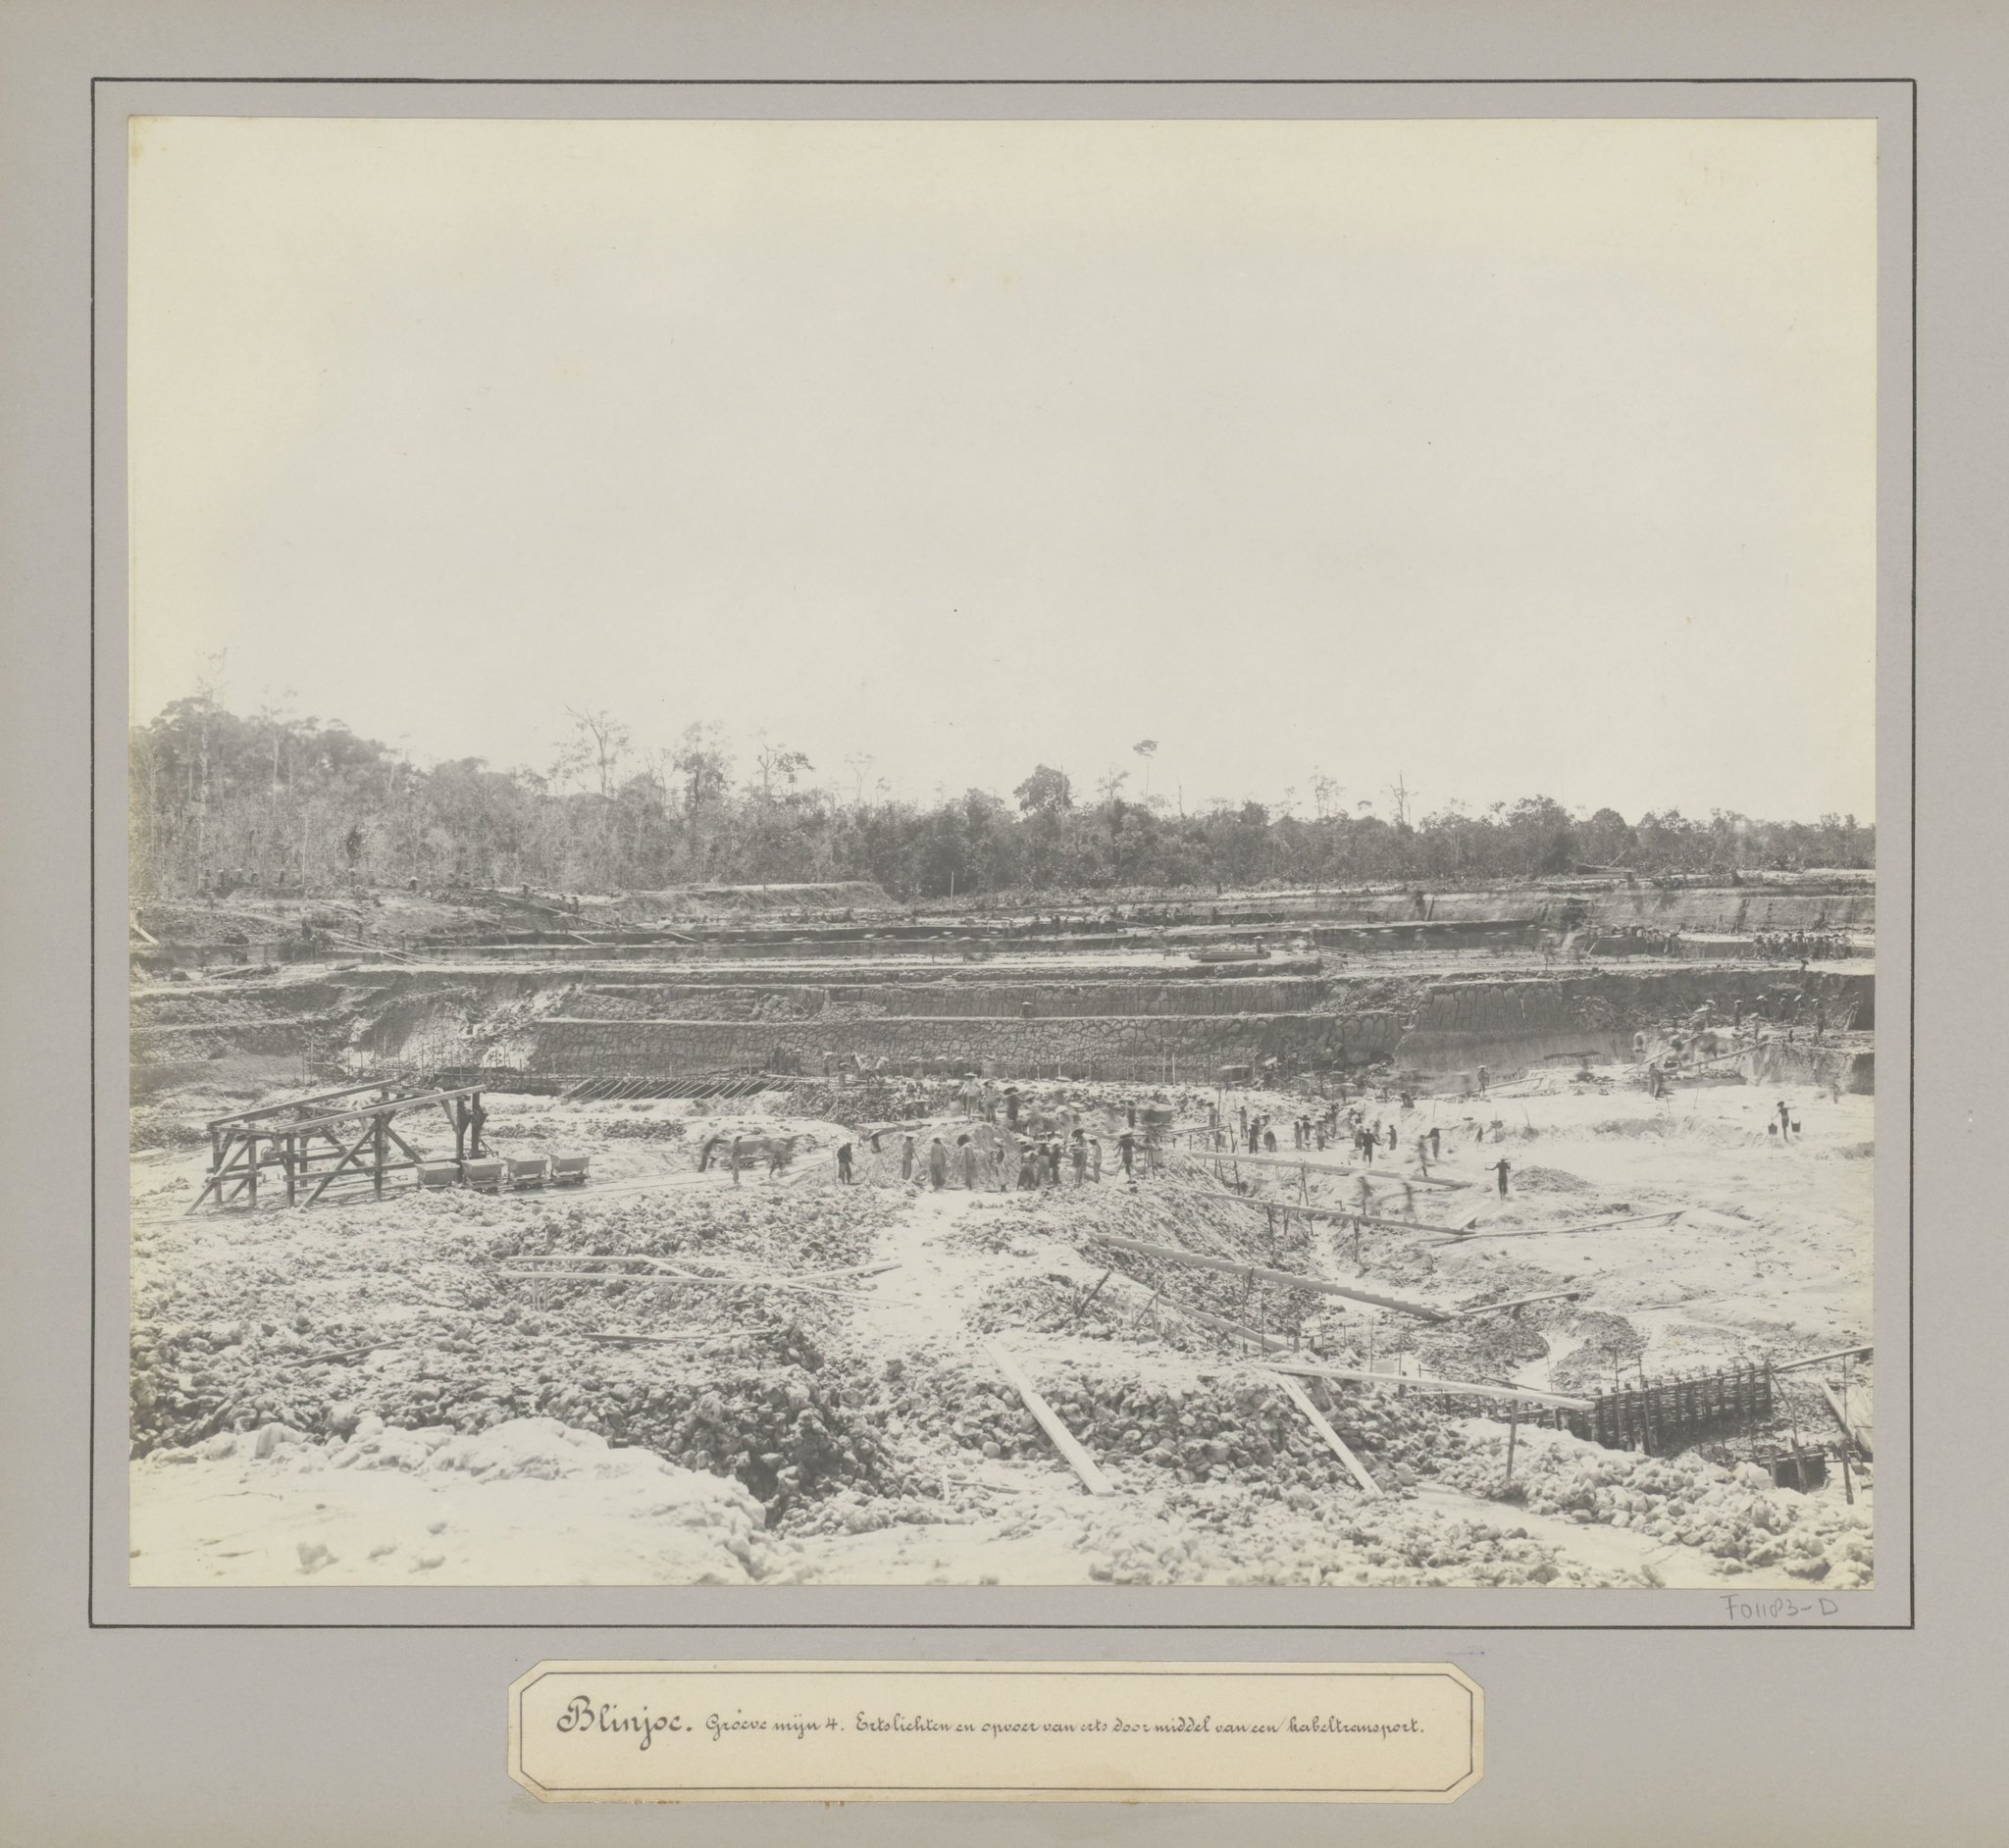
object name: photograph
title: Blinjoe. Groeve mijn 4. Ertslichten en opvoer van erts door middel van een kabeltransport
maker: Anonymous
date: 1900-1920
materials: photographic support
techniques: gelatin silver print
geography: belinyu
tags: mining, minerals and metals: tin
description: Onderdeel van Fotoalbum over de tinwinning op Bangka.